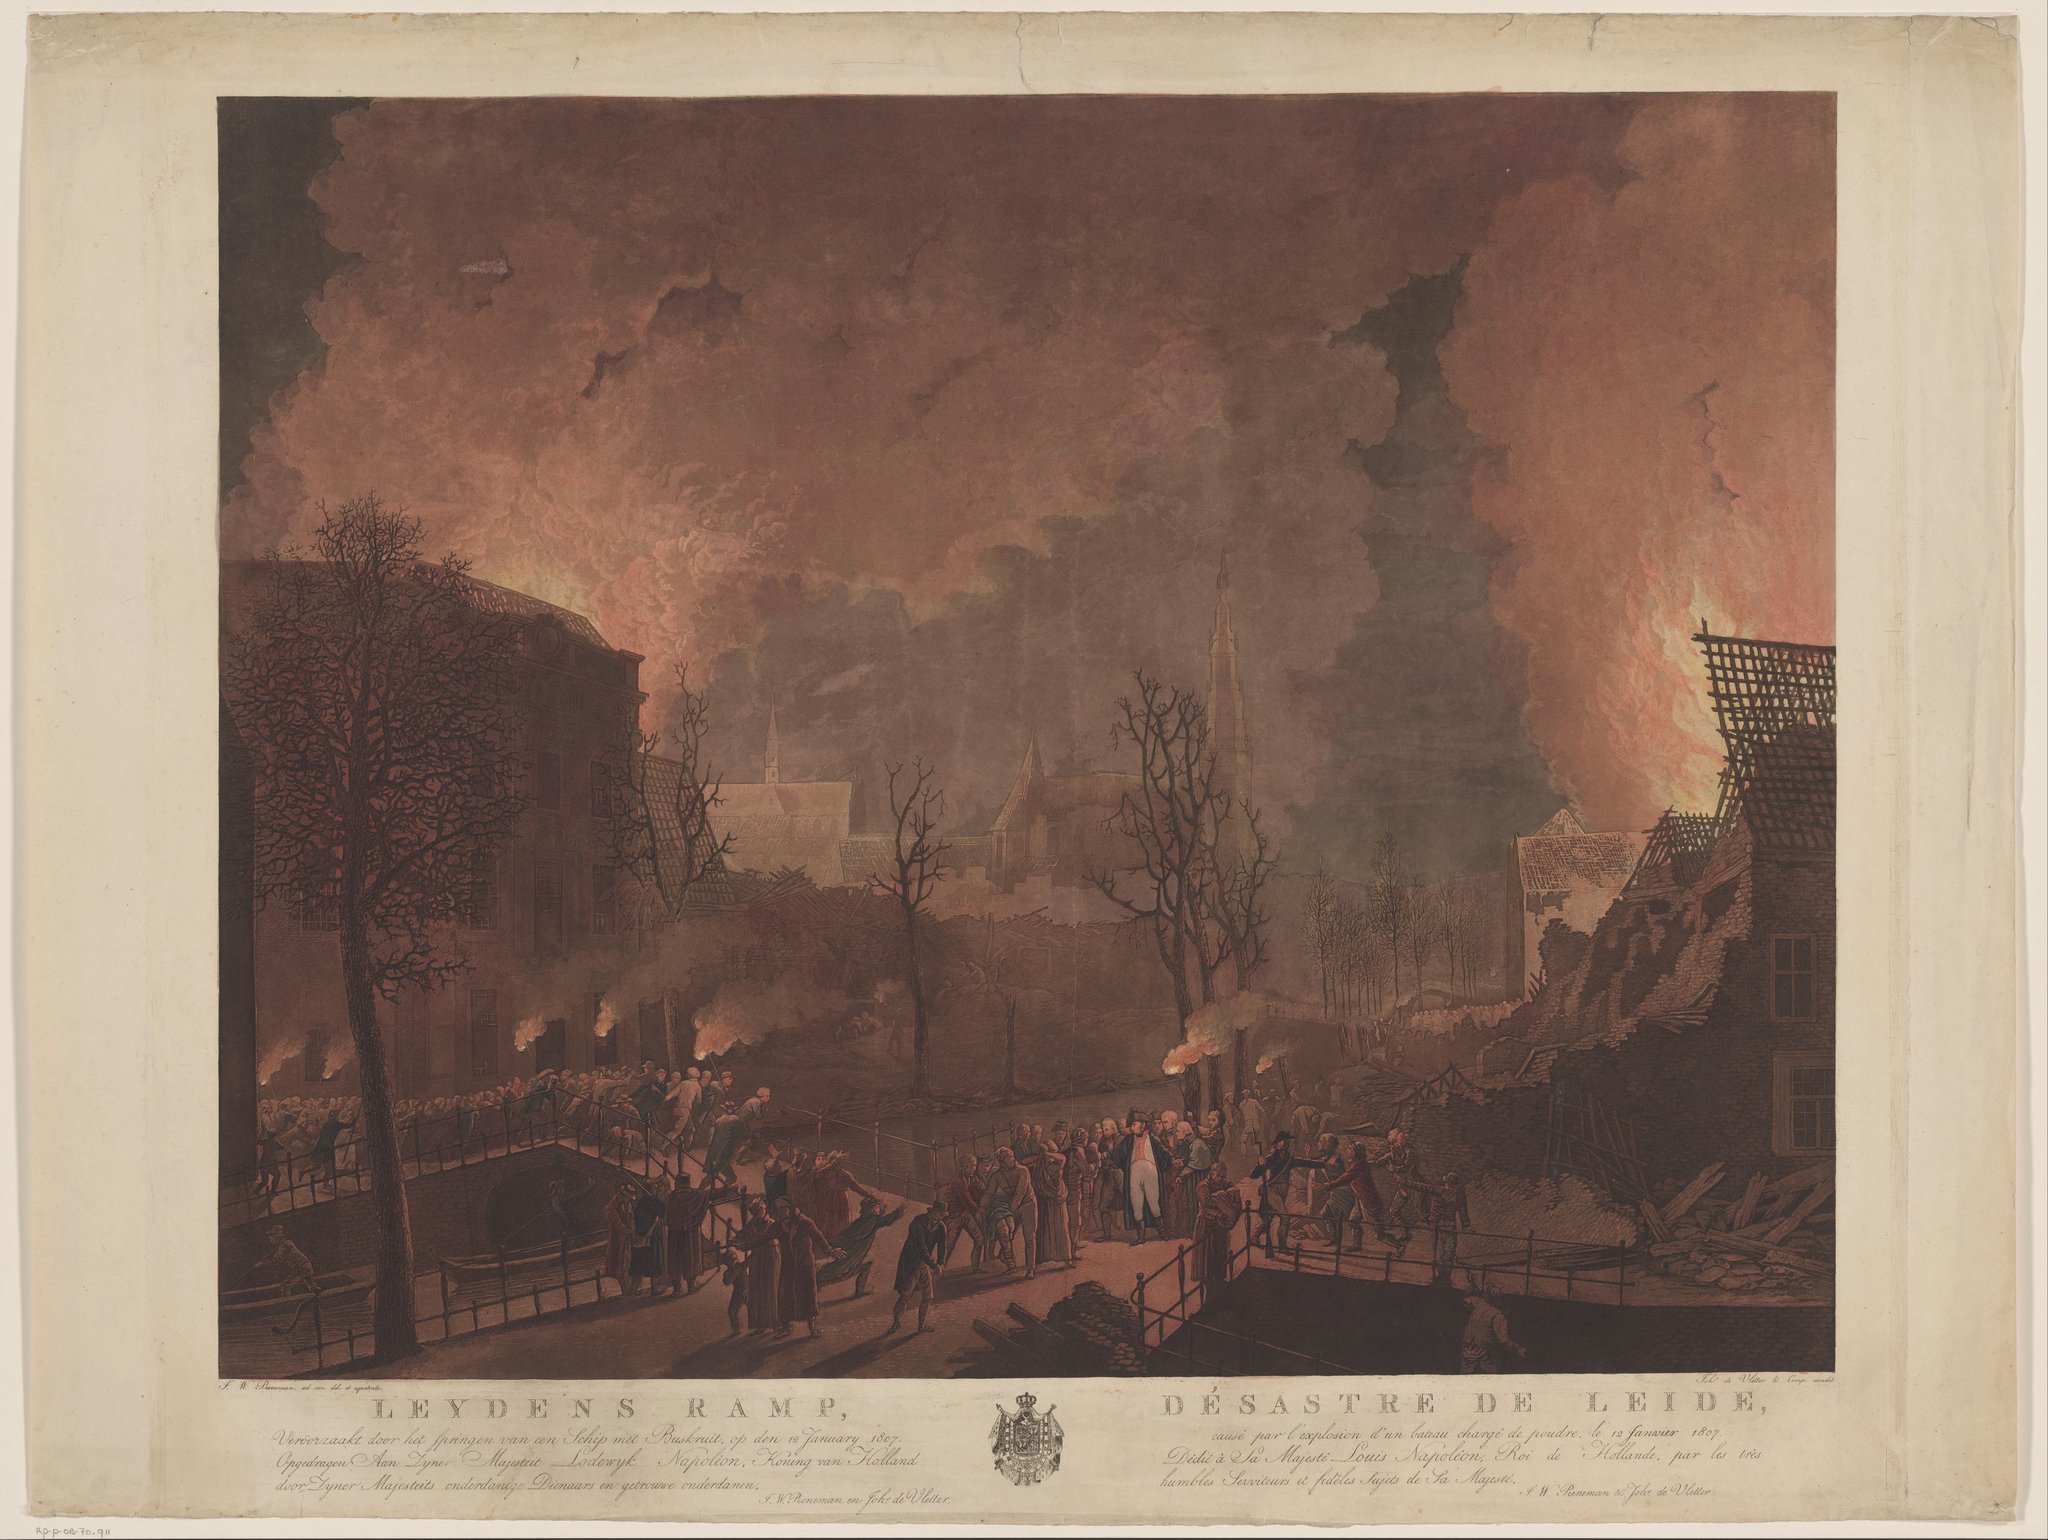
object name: print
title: Leydens Ramp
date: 1807-1828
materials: paper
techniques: aquatint, etching, hand coloring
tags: armorial bearing, heraldry, gunpowder disaster, leiden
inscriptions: collector's mark: Lugt 2228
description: De locatie van de ramp was het Steenschuur, een gracht in het verlengde van het Rapenburg.